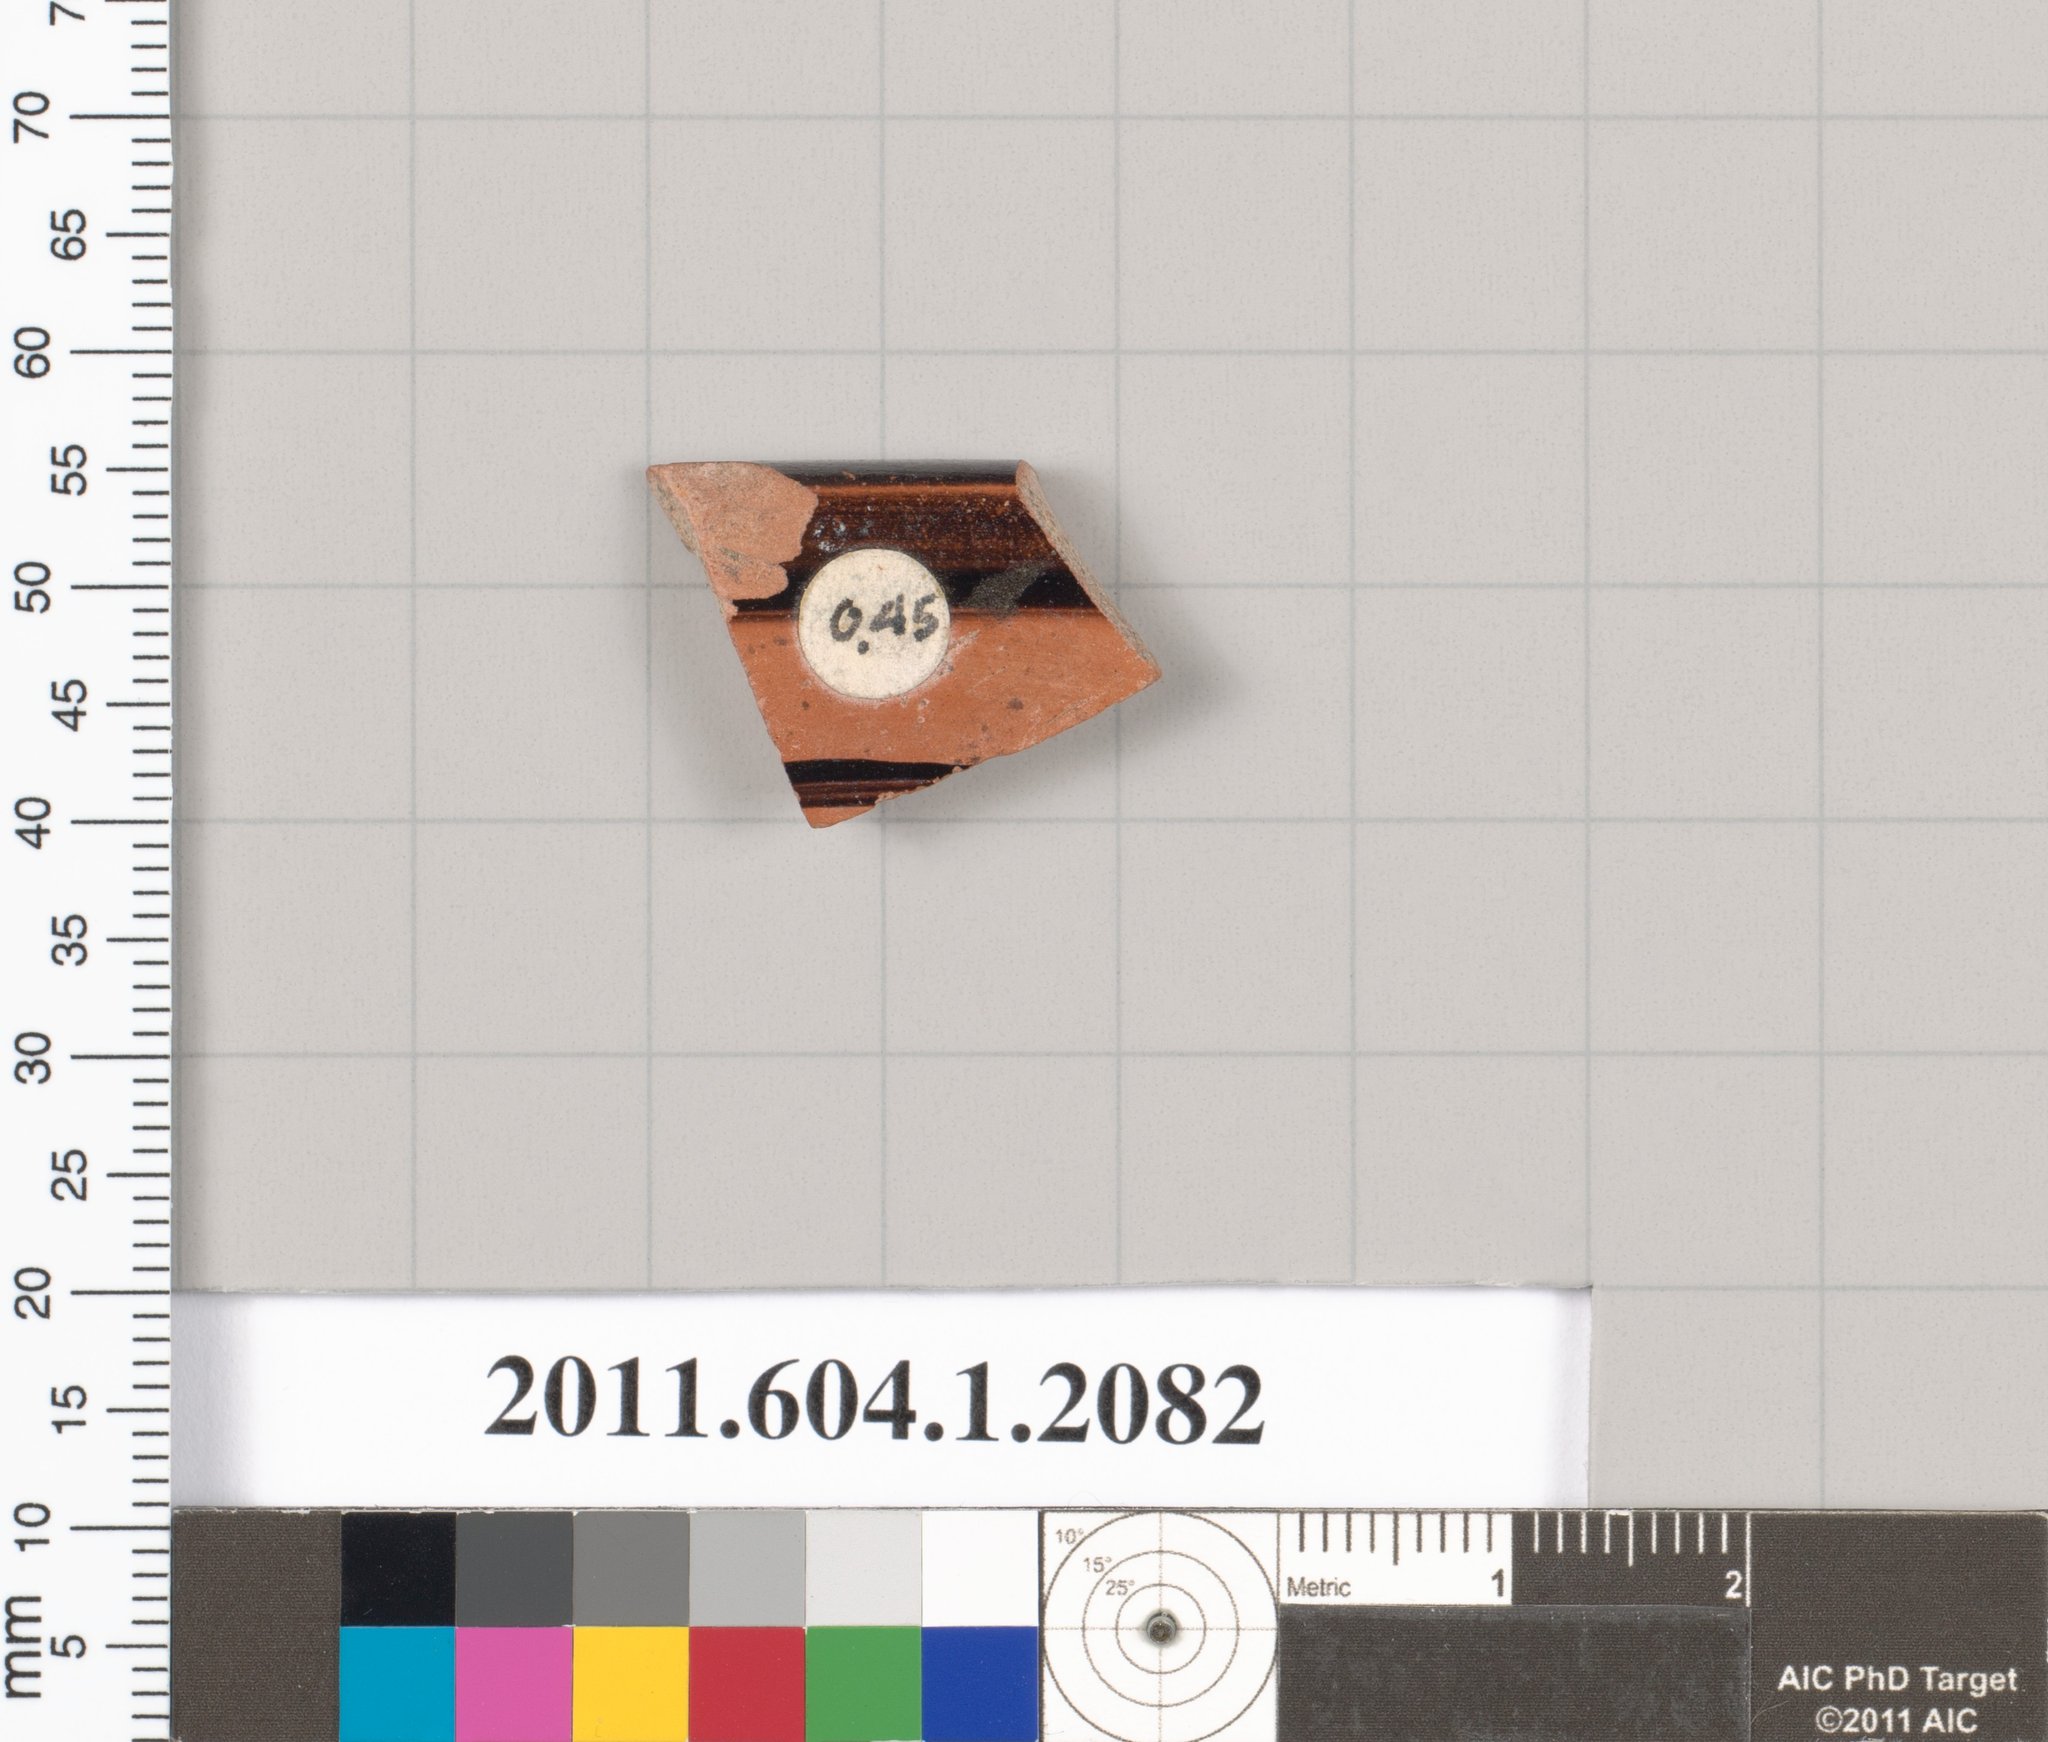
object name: kylix fragment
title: Terracotta rim fragment of a kylix? (drinking cup)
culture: greek, attic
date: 500-401 BCE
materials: terracotta